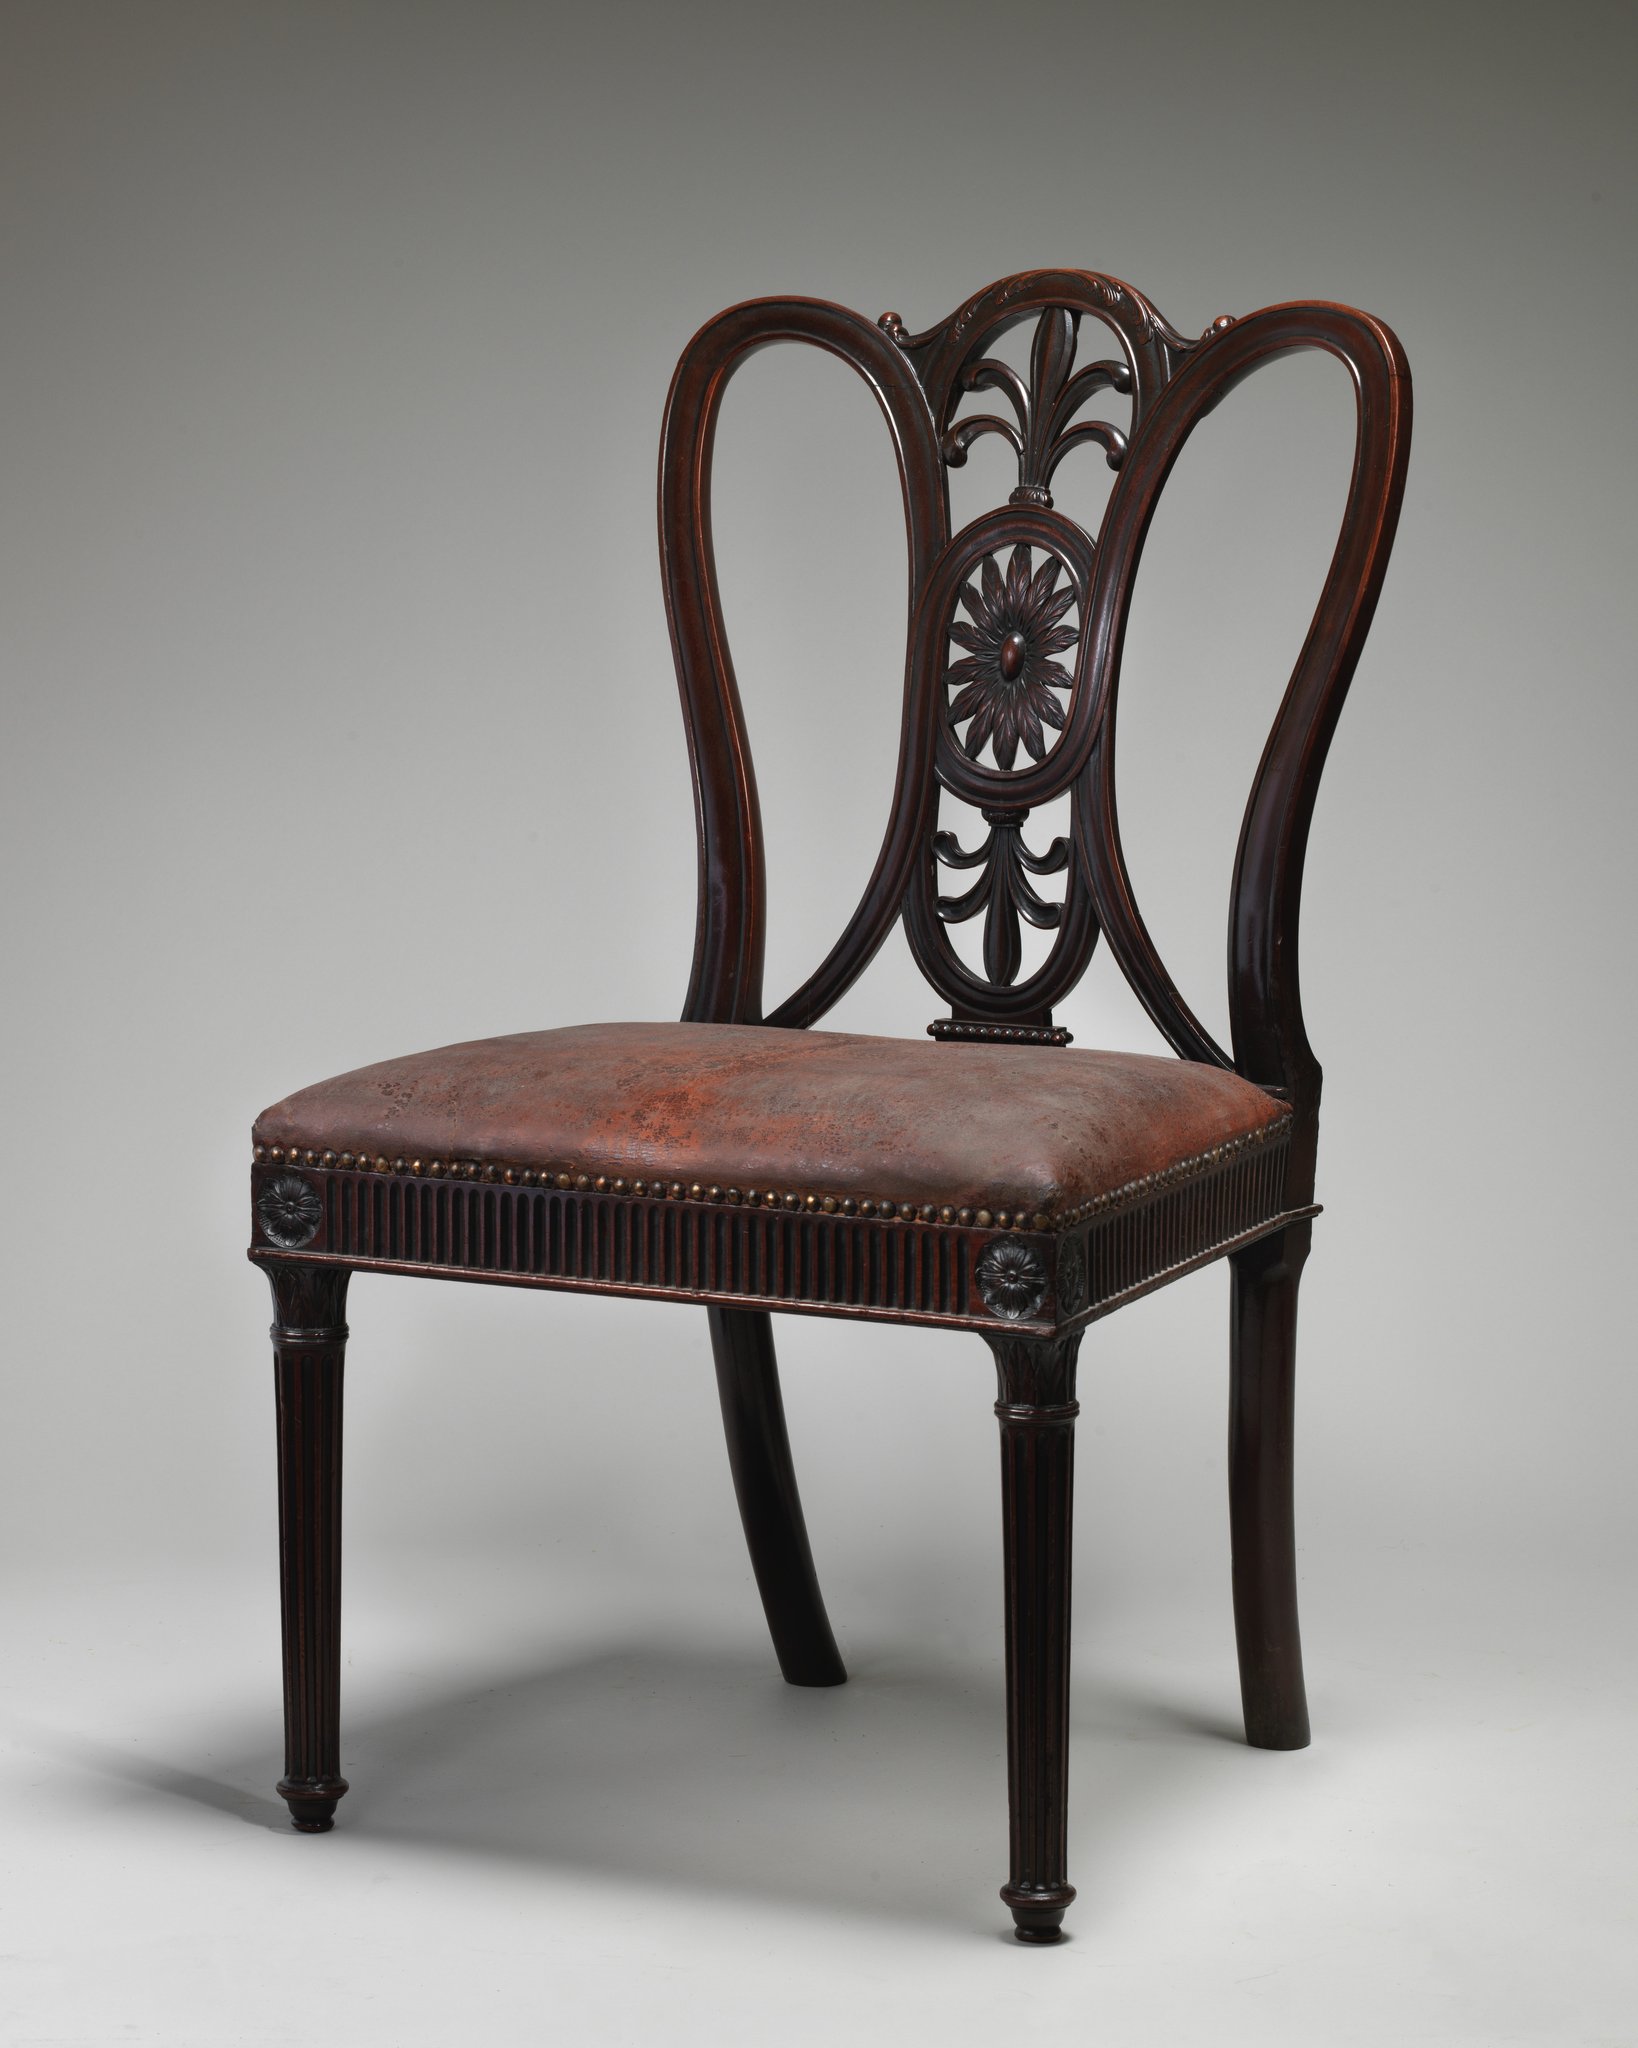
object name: chair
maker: james wyatt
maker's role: designer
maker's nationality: british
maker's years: 1746-1813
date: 1775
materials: leather, wood